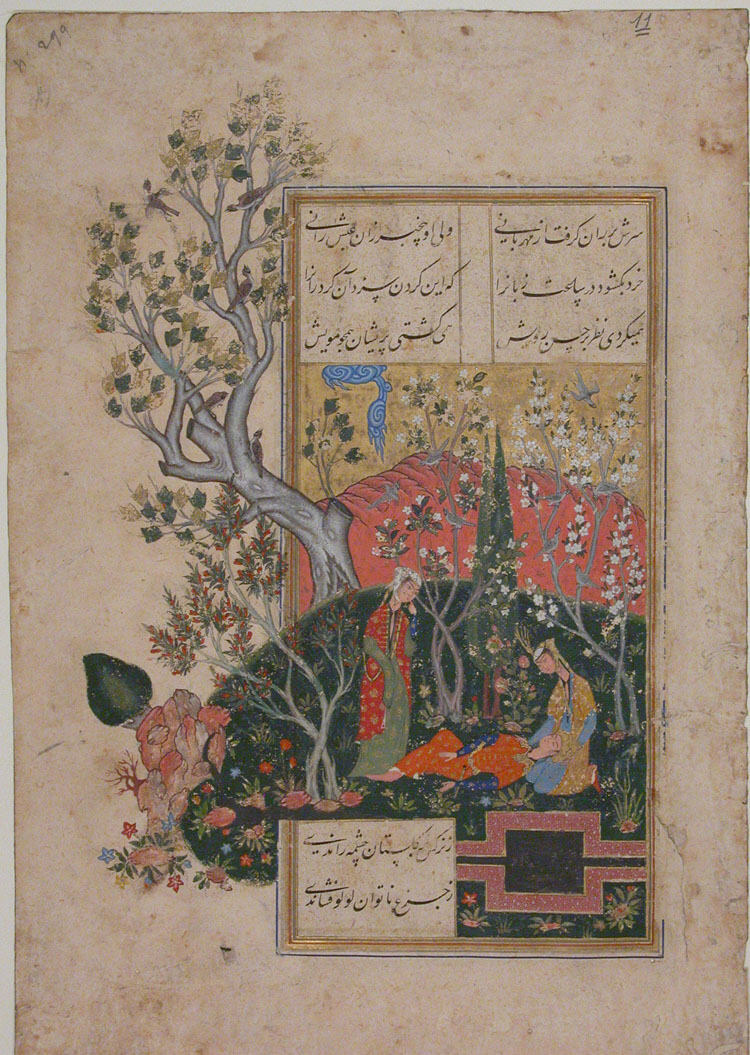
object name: folio from an illustrated manuscript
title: Prince Swooning and Two Ladies in a Landscape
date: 1551-1600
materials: gold, ink, paper, silver, watercolor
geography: iran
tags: princes,women,landscapes